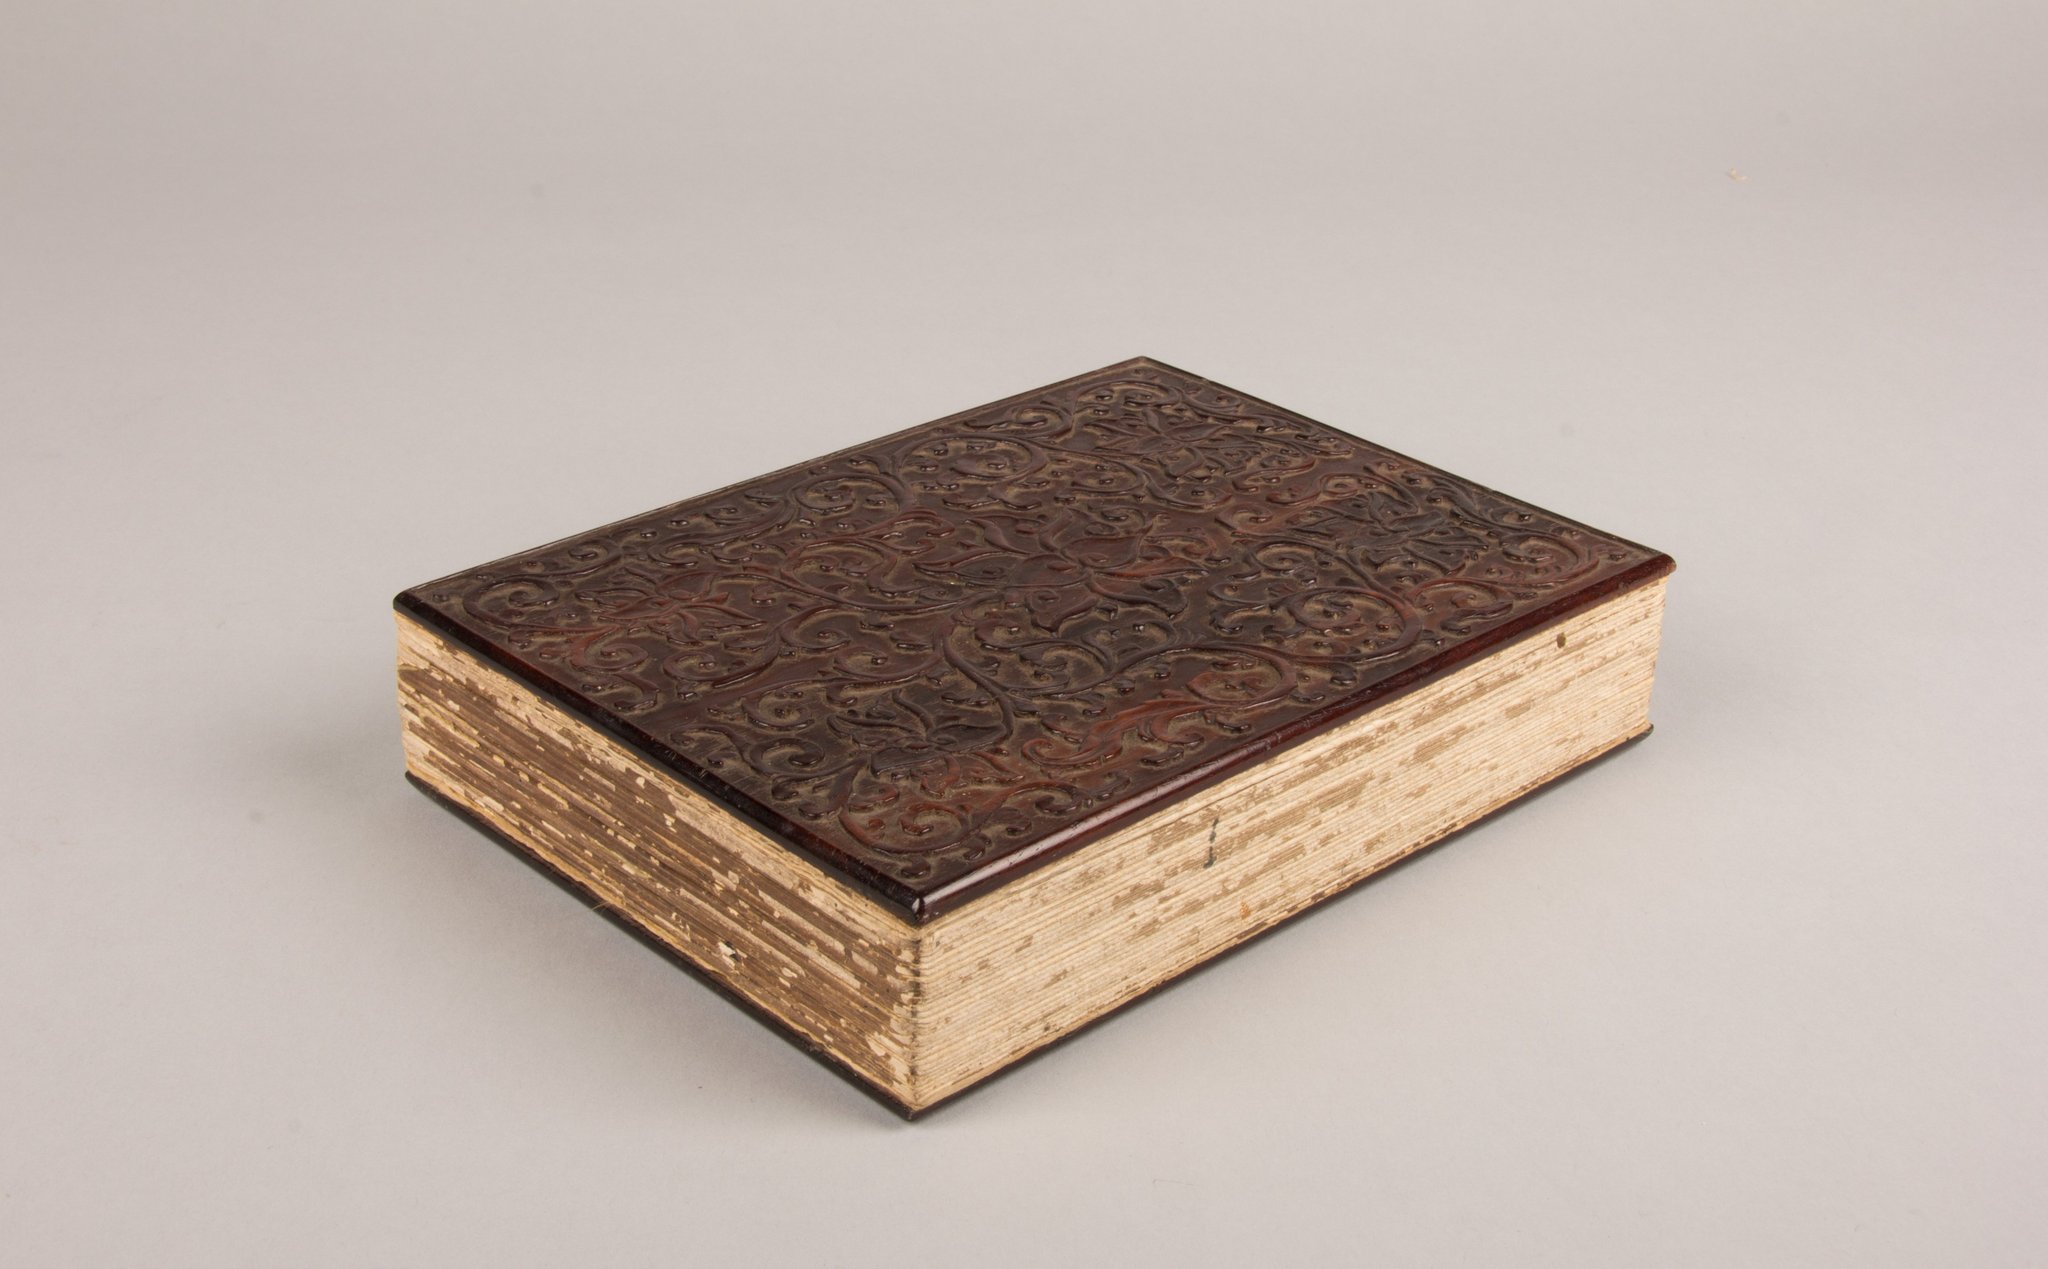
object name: book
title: Record of the Commemorative Tablet by Imperial Manufacture of the Great Buddha Temple of Longxing at Zhengding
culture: chinese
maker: dong gao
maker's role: artist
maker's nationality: chinese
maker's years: 1740-1818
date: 1644-1911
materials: jade, wood